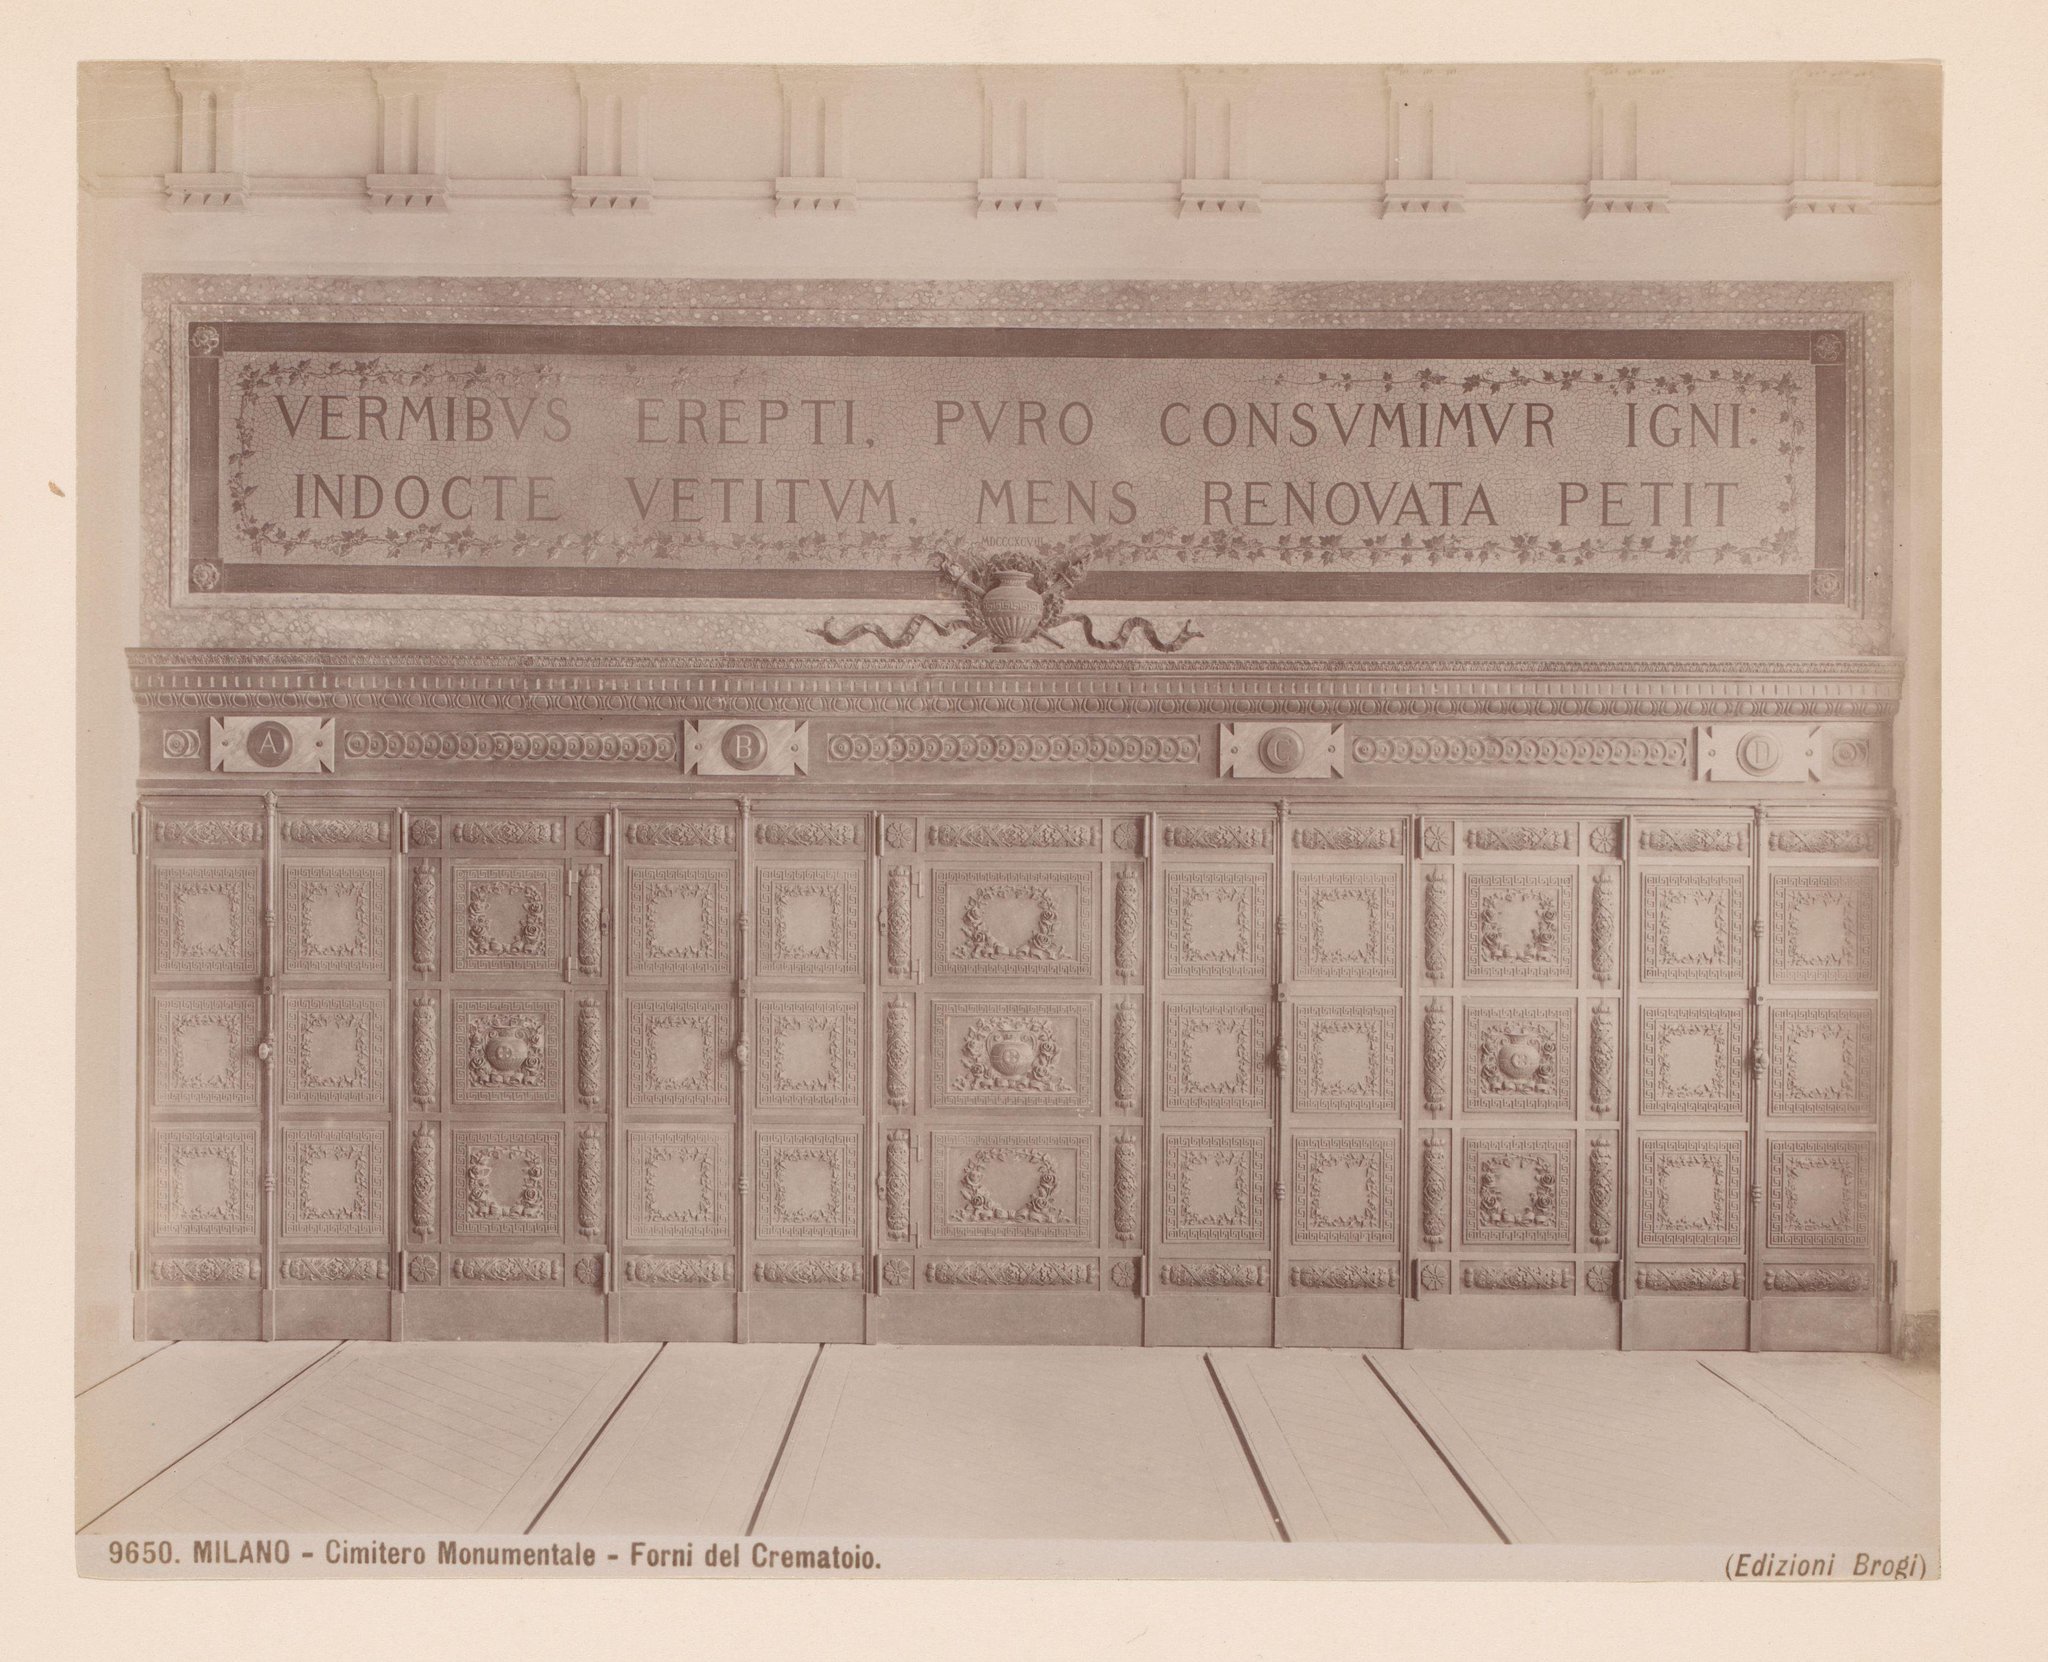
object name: photograph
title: Detail van het monument Cova Chierichetti, Cimitero Monumentale, Milaan, Italië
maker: giacomo brogi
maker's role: fotograaf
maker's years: 1822-1881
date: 1860-1890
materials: cardboard, paper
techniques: albumen print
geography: florence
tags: milaan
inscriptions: caption: ‘(BROGI)’, caption: ‘10788. MILANO - Cimetero Monumentale - Particolare del monumento Cova Chierichetti; scultore G. Strazza’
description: Detail van monumento Cova Chierichetti met sculptuur van G. Strazza.